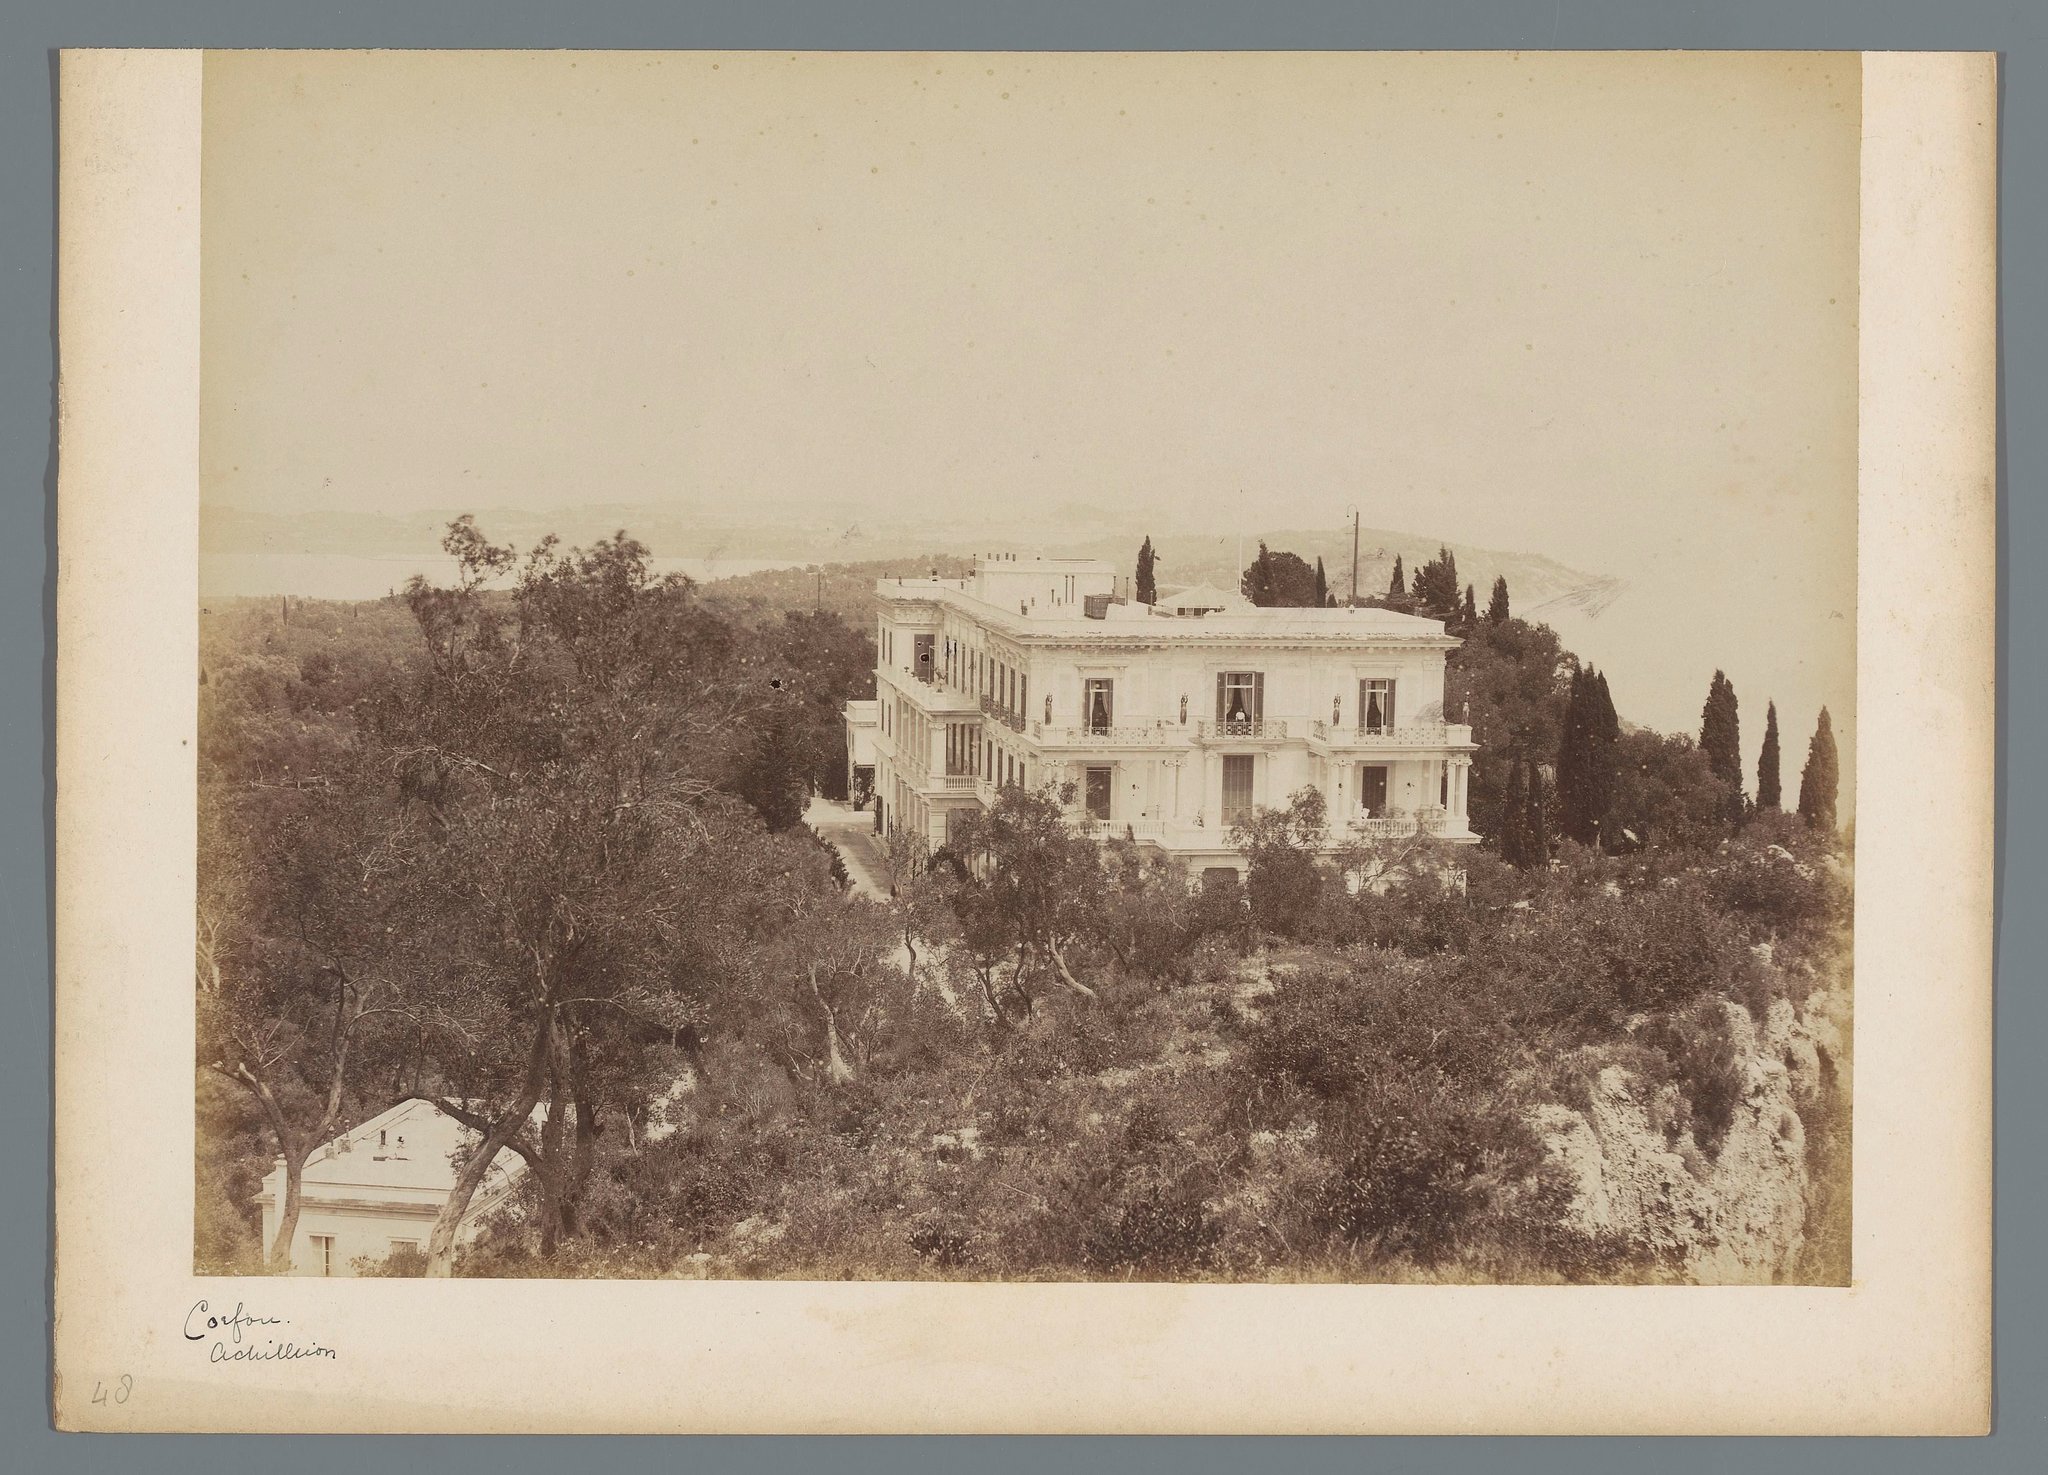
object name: photograph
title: Corfou, Achilleion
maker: Anonymous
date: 1889-1900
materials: cardboard, paper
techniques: albumen print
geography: corfu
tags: palace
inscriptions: number: ‘1899’